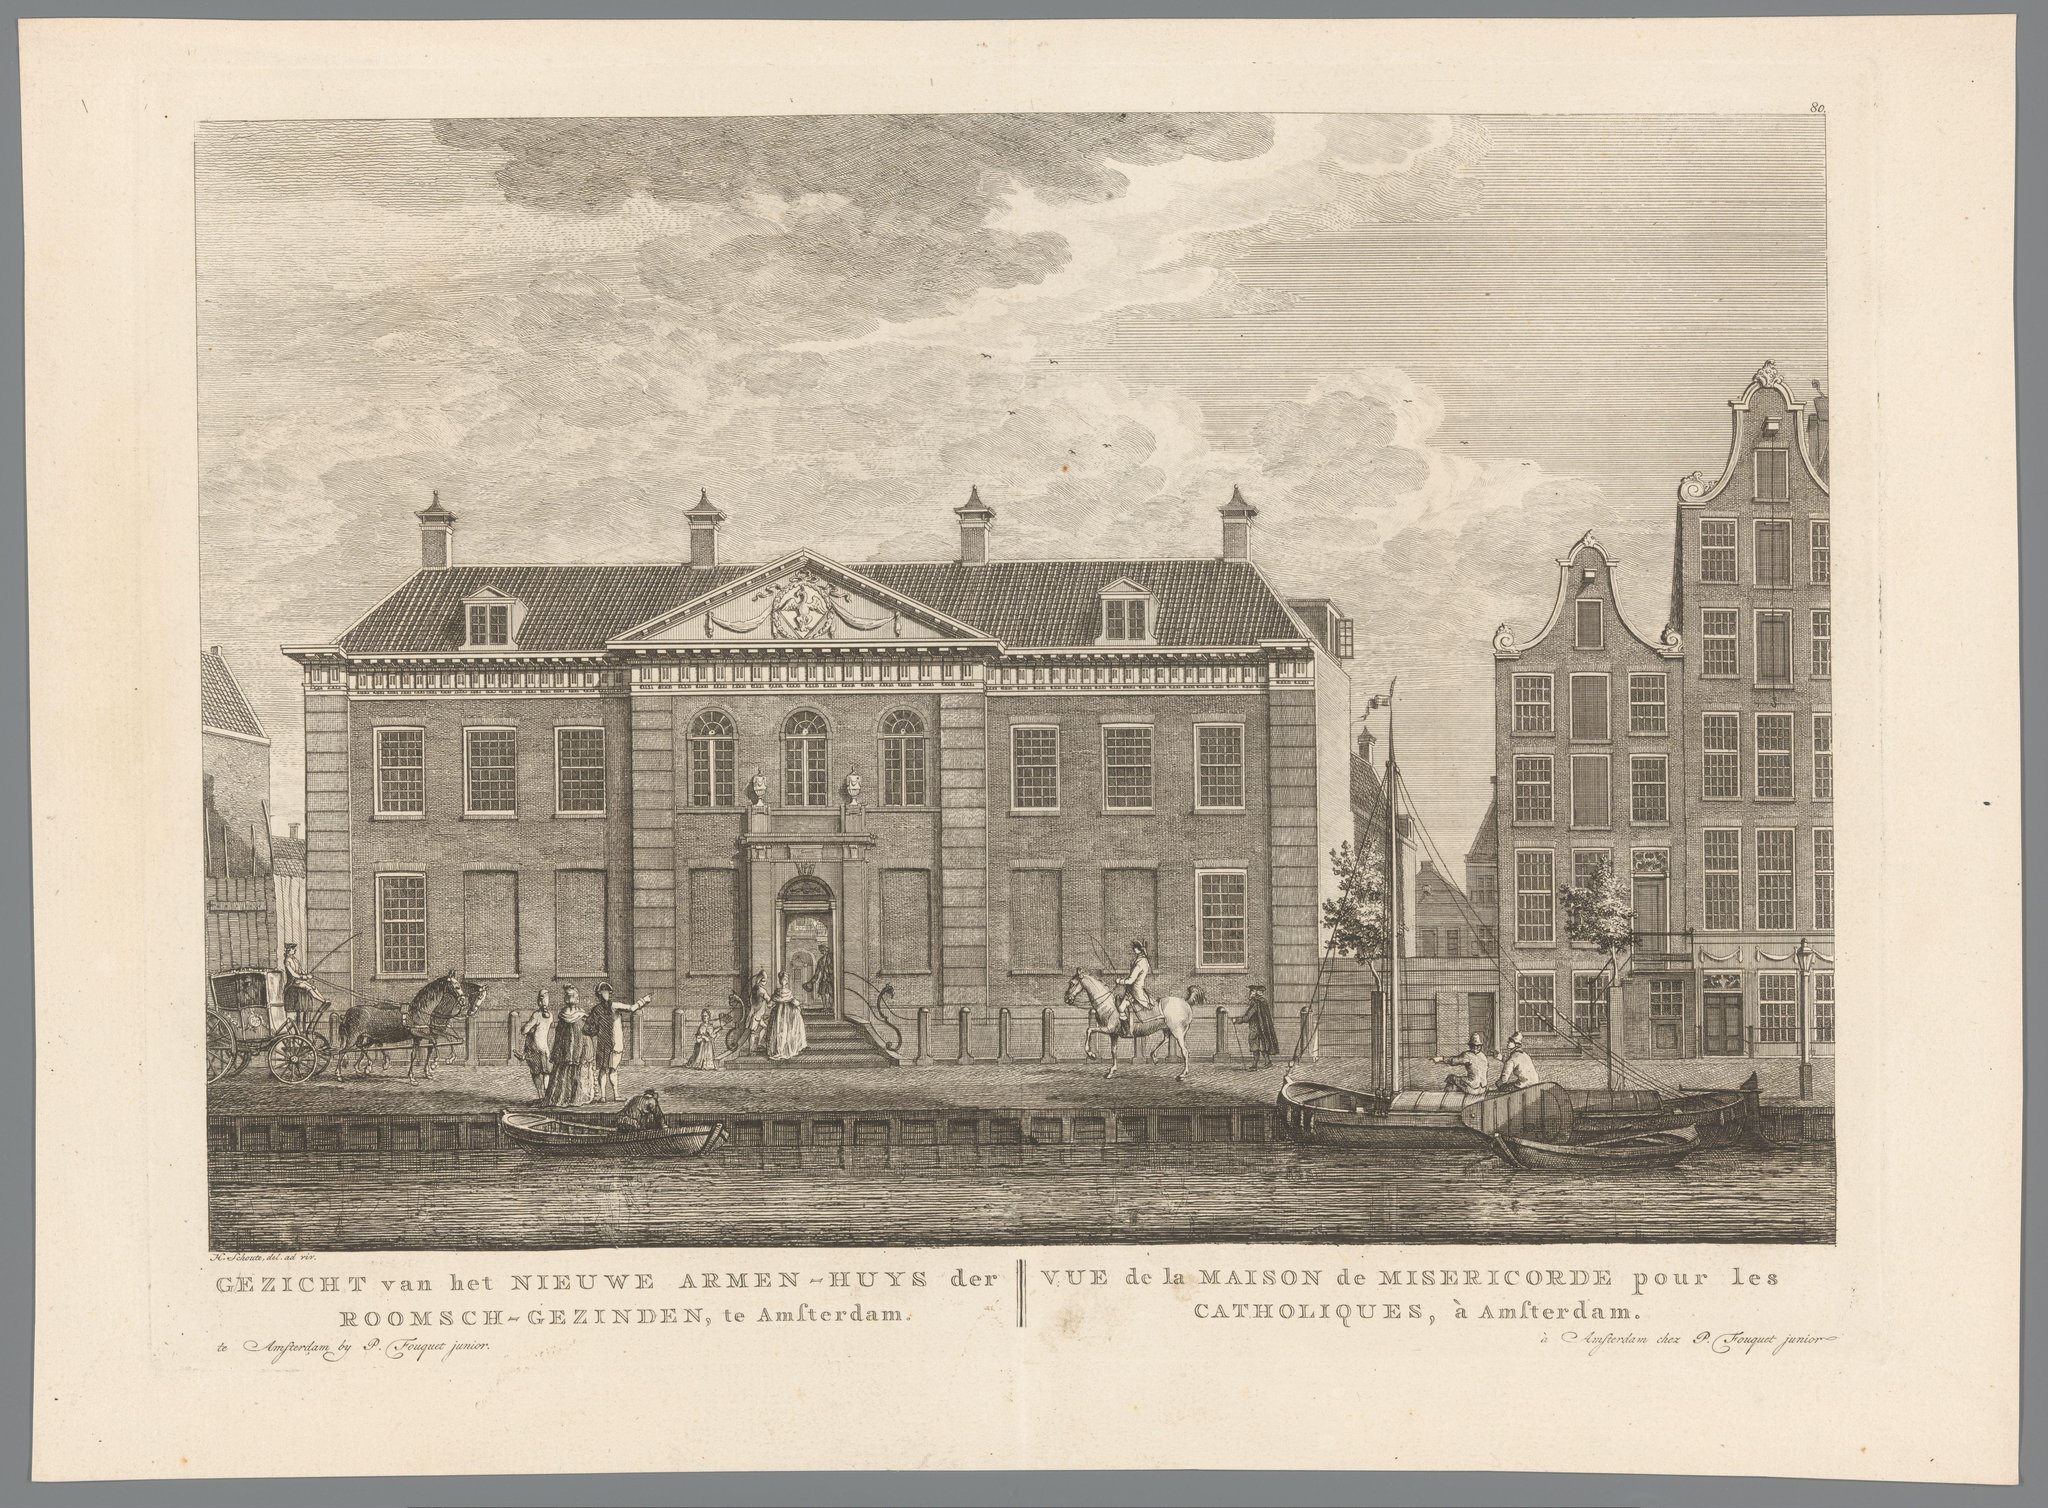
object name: print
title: Gezicht op het Gebouw van Barmhartigheid te Amsterdam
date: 1774-1783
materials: paper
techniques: etching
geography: amsterdam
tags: canals, waters (in city), old-people's home, street (+ city(-scape) with figures, staffage)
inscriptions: collector's mark: Lugt 2233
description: Vanaf 1760 gaf Pierre Fouquet stadsgezichten van Amsterdam naar tekeningen van verschillende kunstenaars uit. Deze prenten werden aanvankelijk los verkocht. Later werden ze samengebonden verkocht in verschillende volgordes en aantallen in: (1). Afbeeldingen van de wyd-vermaarde koopstad Amsterdam benevens des zelvs voornaamste gebouwen en gezigten alle naar het leeven getekend / Receuil des edifices les plus considerables et des plus belles vues, de la fameuse ville d'Amsterdam, dessinées d'après nature. Amsterdam: Pierre Fouquet, 1778-1783. (2). Nieuwe atlas, van de voornaamste gebouwen en gezigten der stad Amsterdam, met derzelver beknopte beschryvingen. 2 dln. Amsterdam: Daniël Jean Changuion en Petrus den Hengst [in opdracht van Pierre Fouquet], 1783. Ook werden er door verschillende uitgevers tussen 1788 (Amsterdam: Petrus Conradi) en 1805 (Amsterdam: Evert Maaskamp) heruitgaven gepubliceerd.